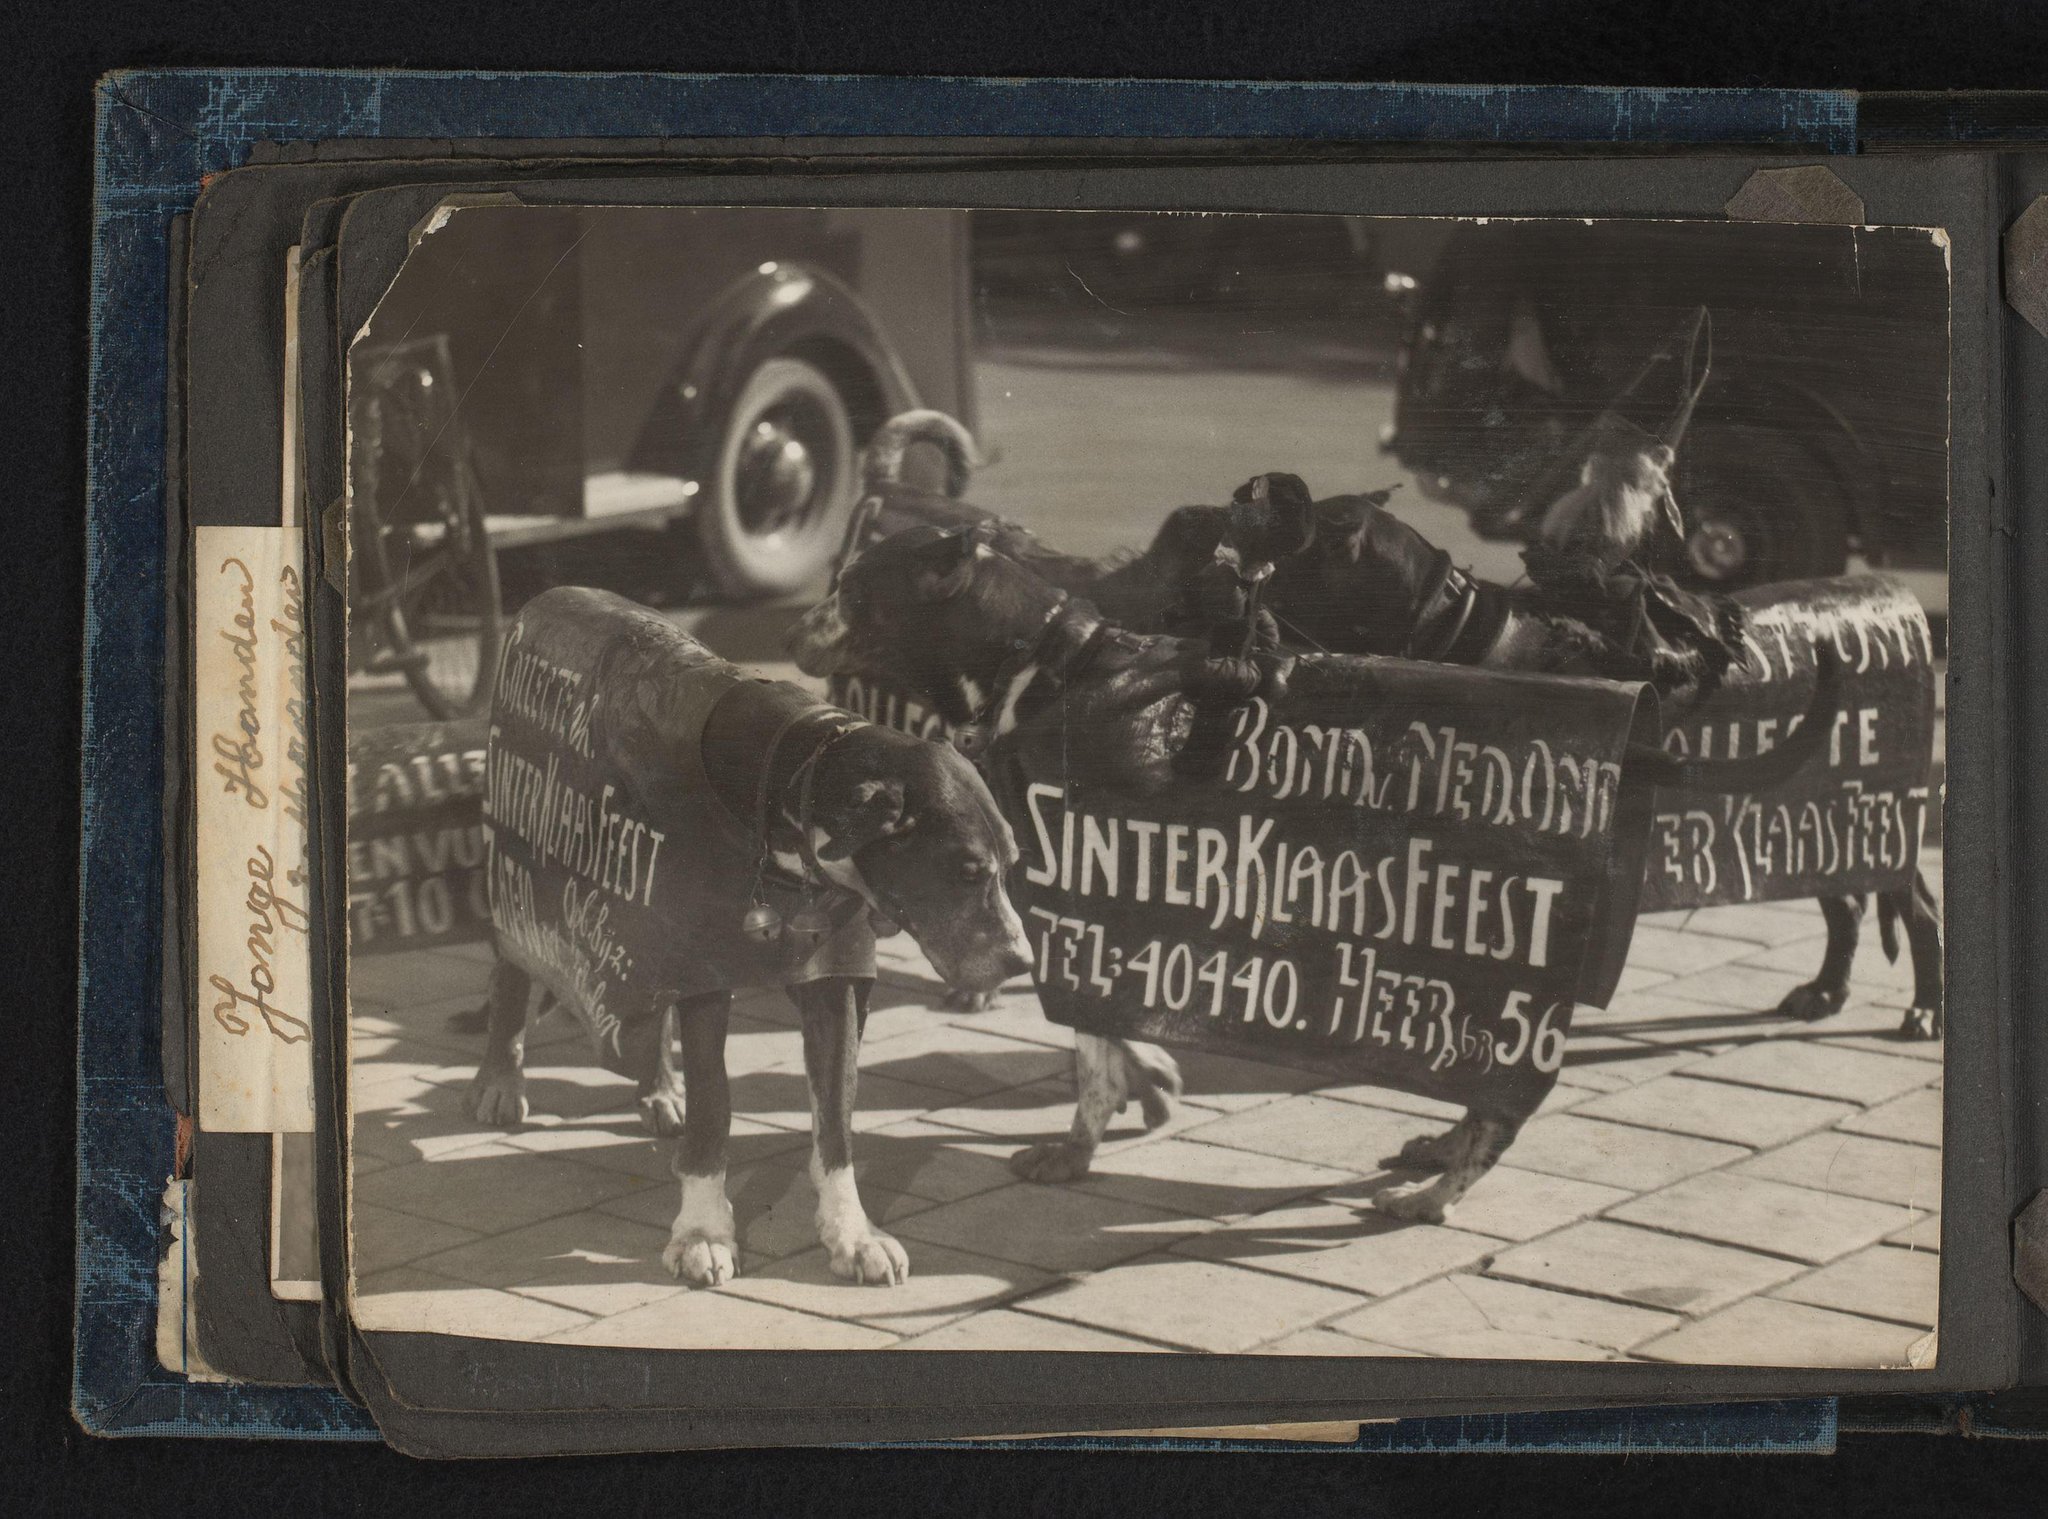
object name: album leaf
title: Honden met reclameteksten voor Sinterklaasaktie van de Bond van Ned. Ond. te Amsterdam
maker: Anonymous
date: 1930-1940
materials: photographic support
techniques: gelatin silver print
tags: advertising, street, dog